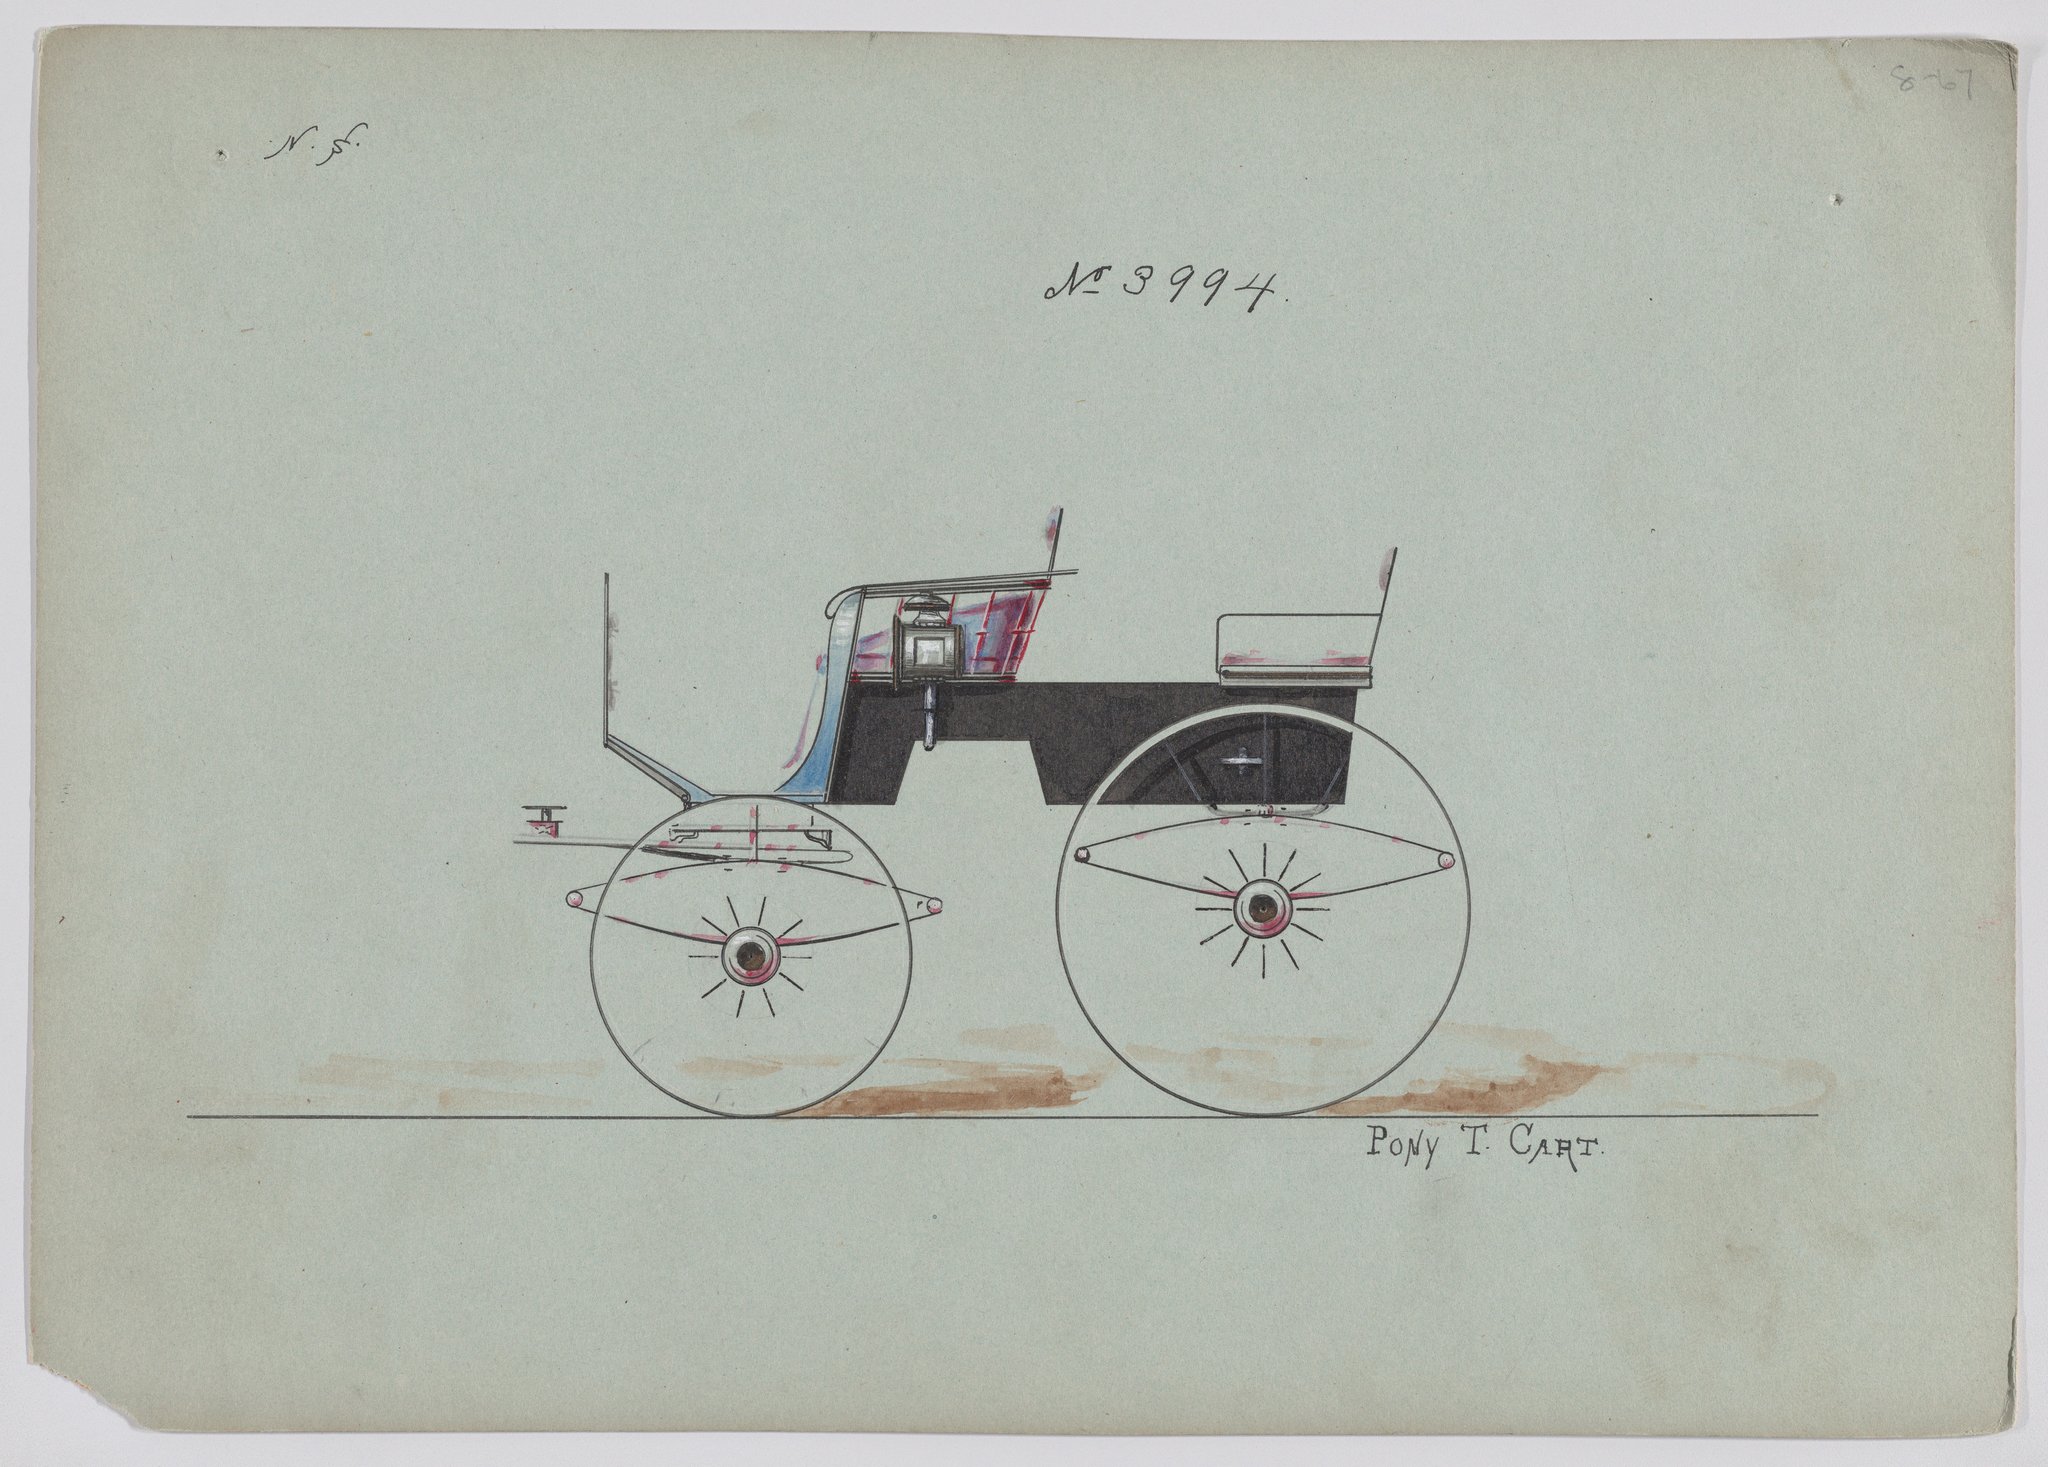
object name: drawing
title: Design for 4 seat Phaeton, no top, no. 3994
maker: brewster & co.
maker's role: manufacturer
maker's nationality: american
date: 1887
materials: gouache, gum arabic, ink, watercolor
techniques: pen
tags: carriages